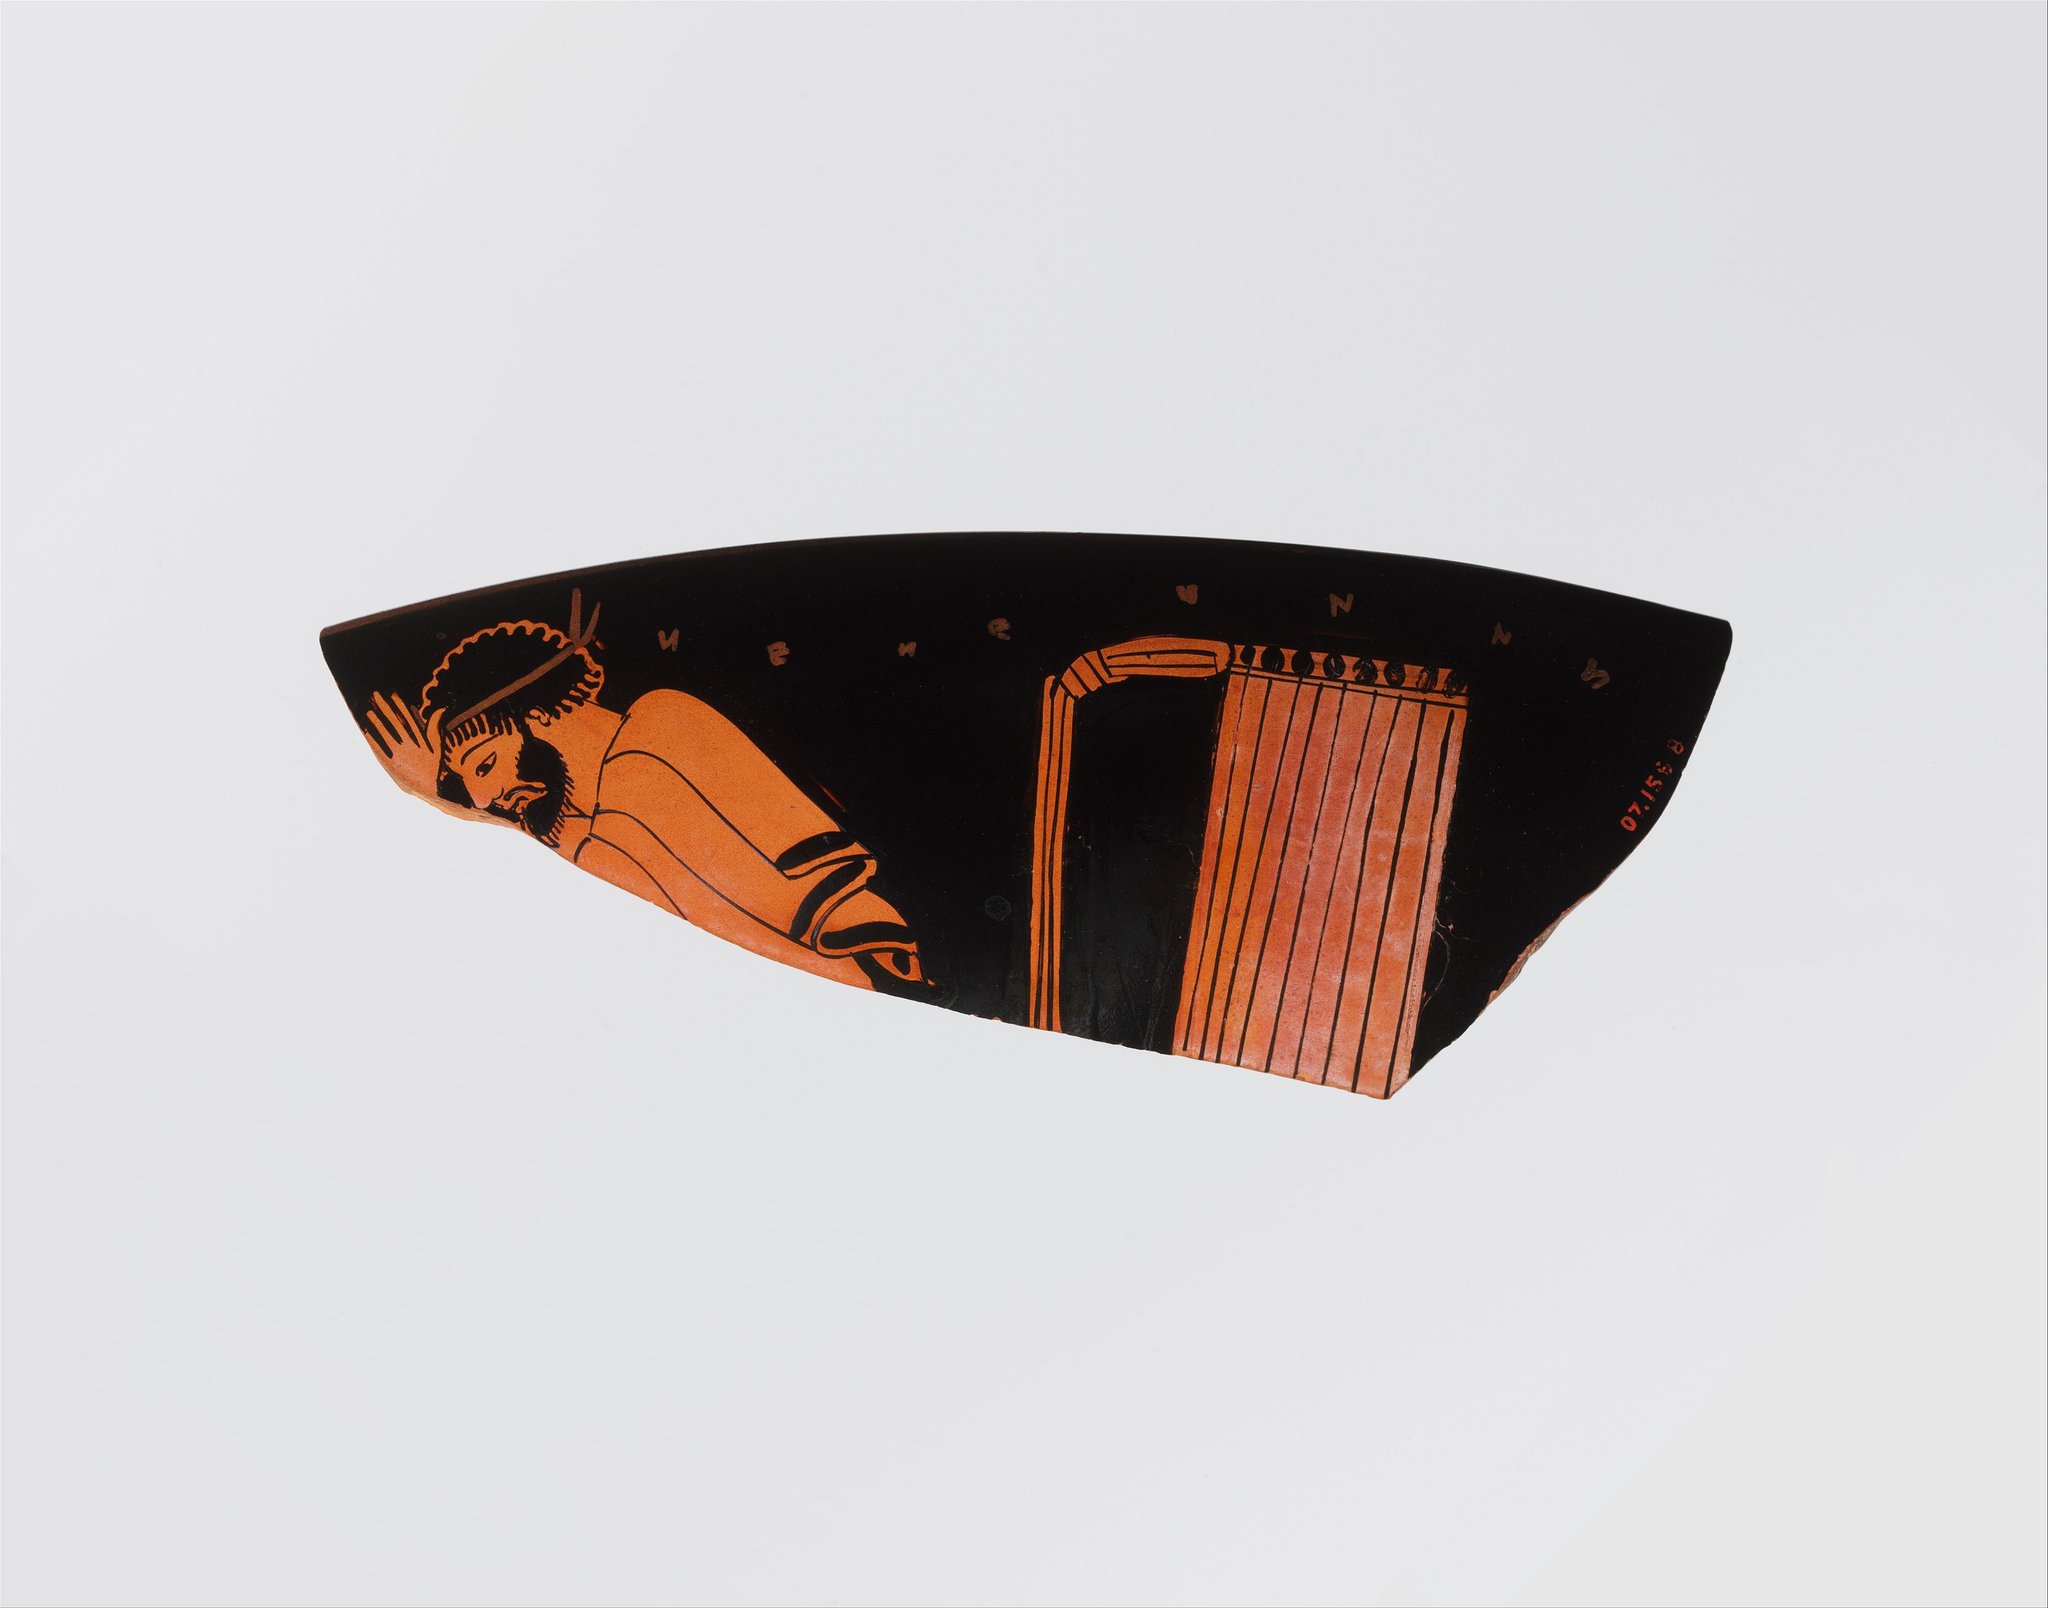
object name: kylix fragment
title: Fragment of a terracotta kylix (drinking cup)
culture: greek, attic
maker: foundry painter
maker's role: artist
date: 480-470 BCE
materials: terracotta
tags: men